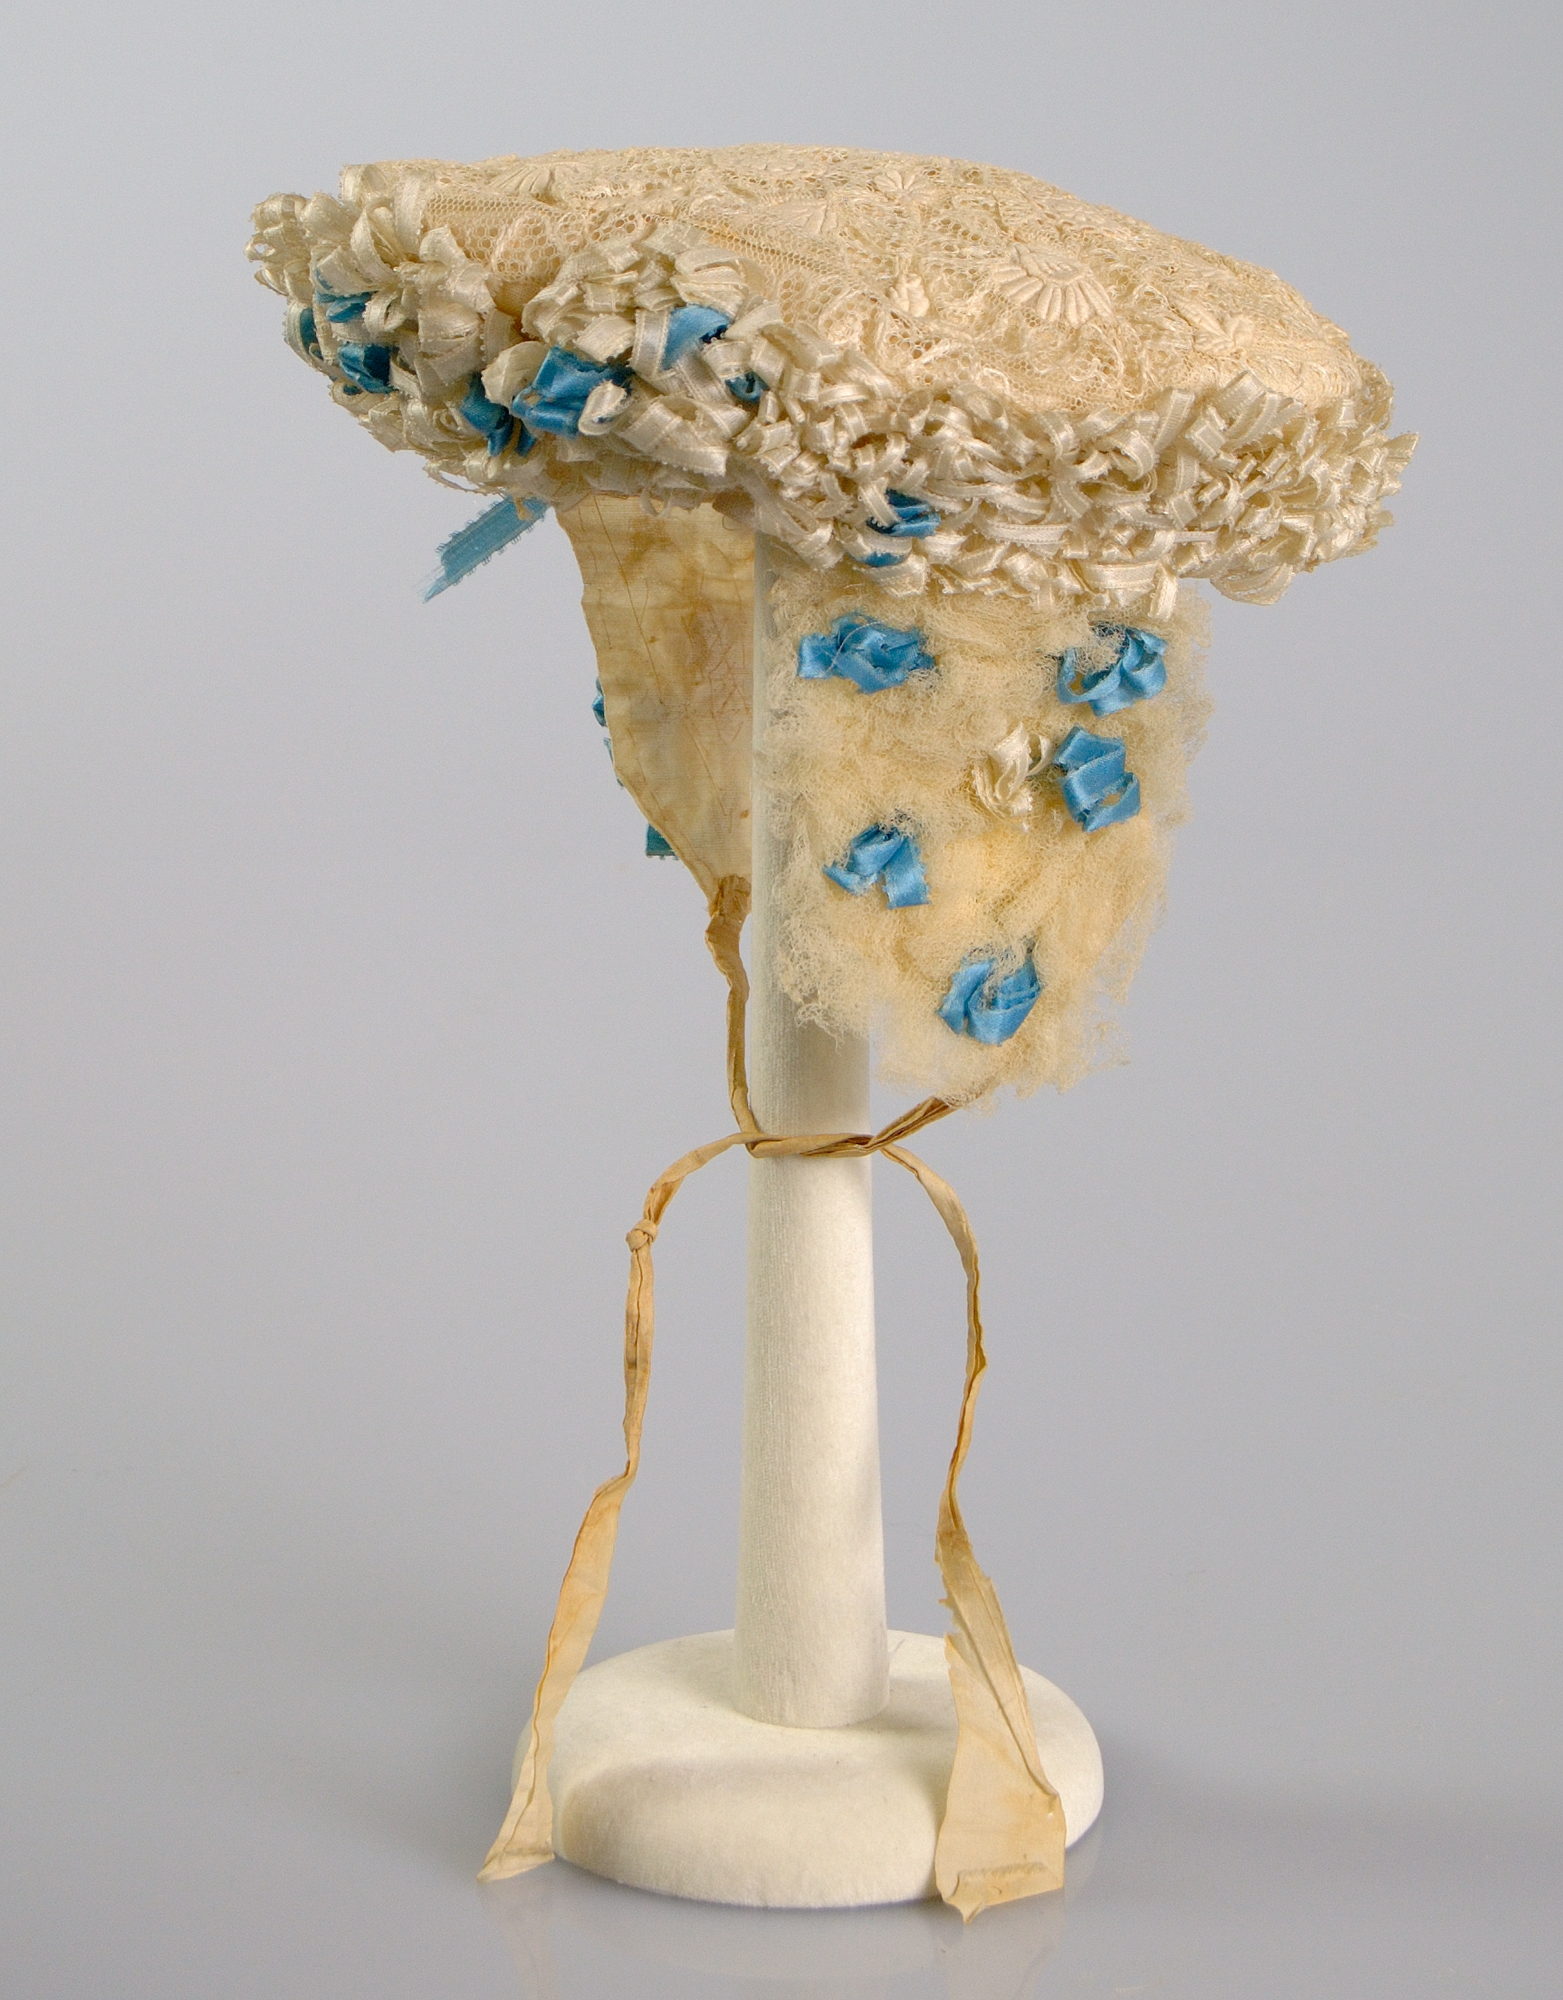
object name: hat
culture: american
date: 1850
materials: cotton, silk